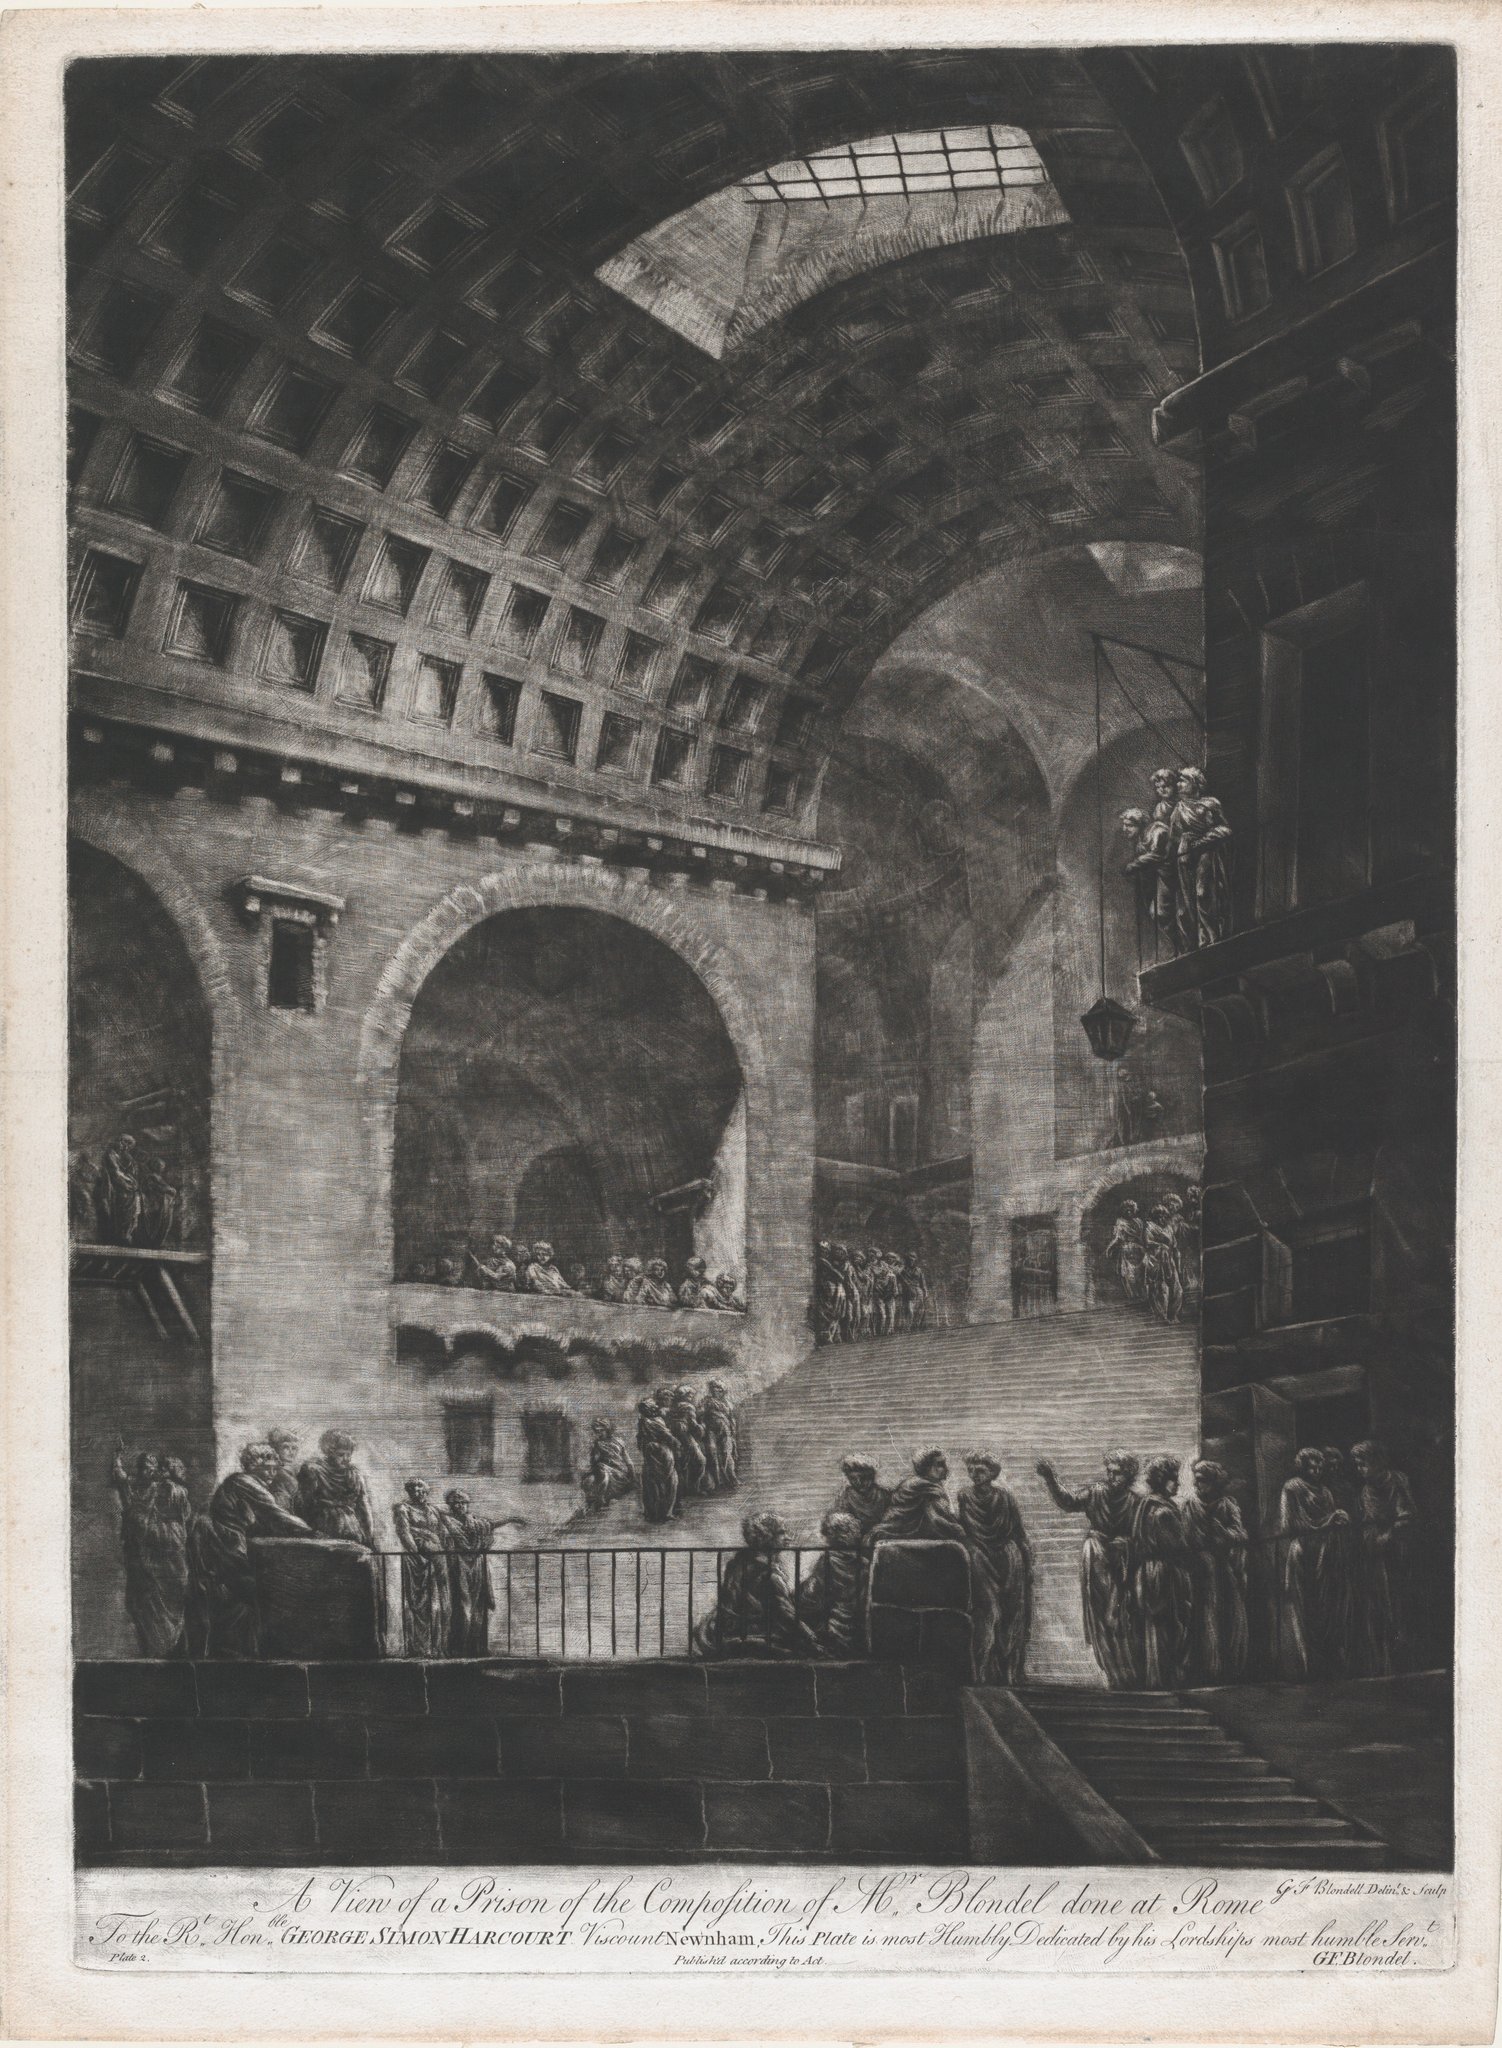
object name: print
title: A View of a Prison of the Composition of Mr. Blondel done at Rome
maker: georges françois blondel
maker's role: artist and publisher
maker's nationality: french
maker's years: 1730-1792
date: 1765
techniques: mezzotint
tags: prisons,interiors,prisoners